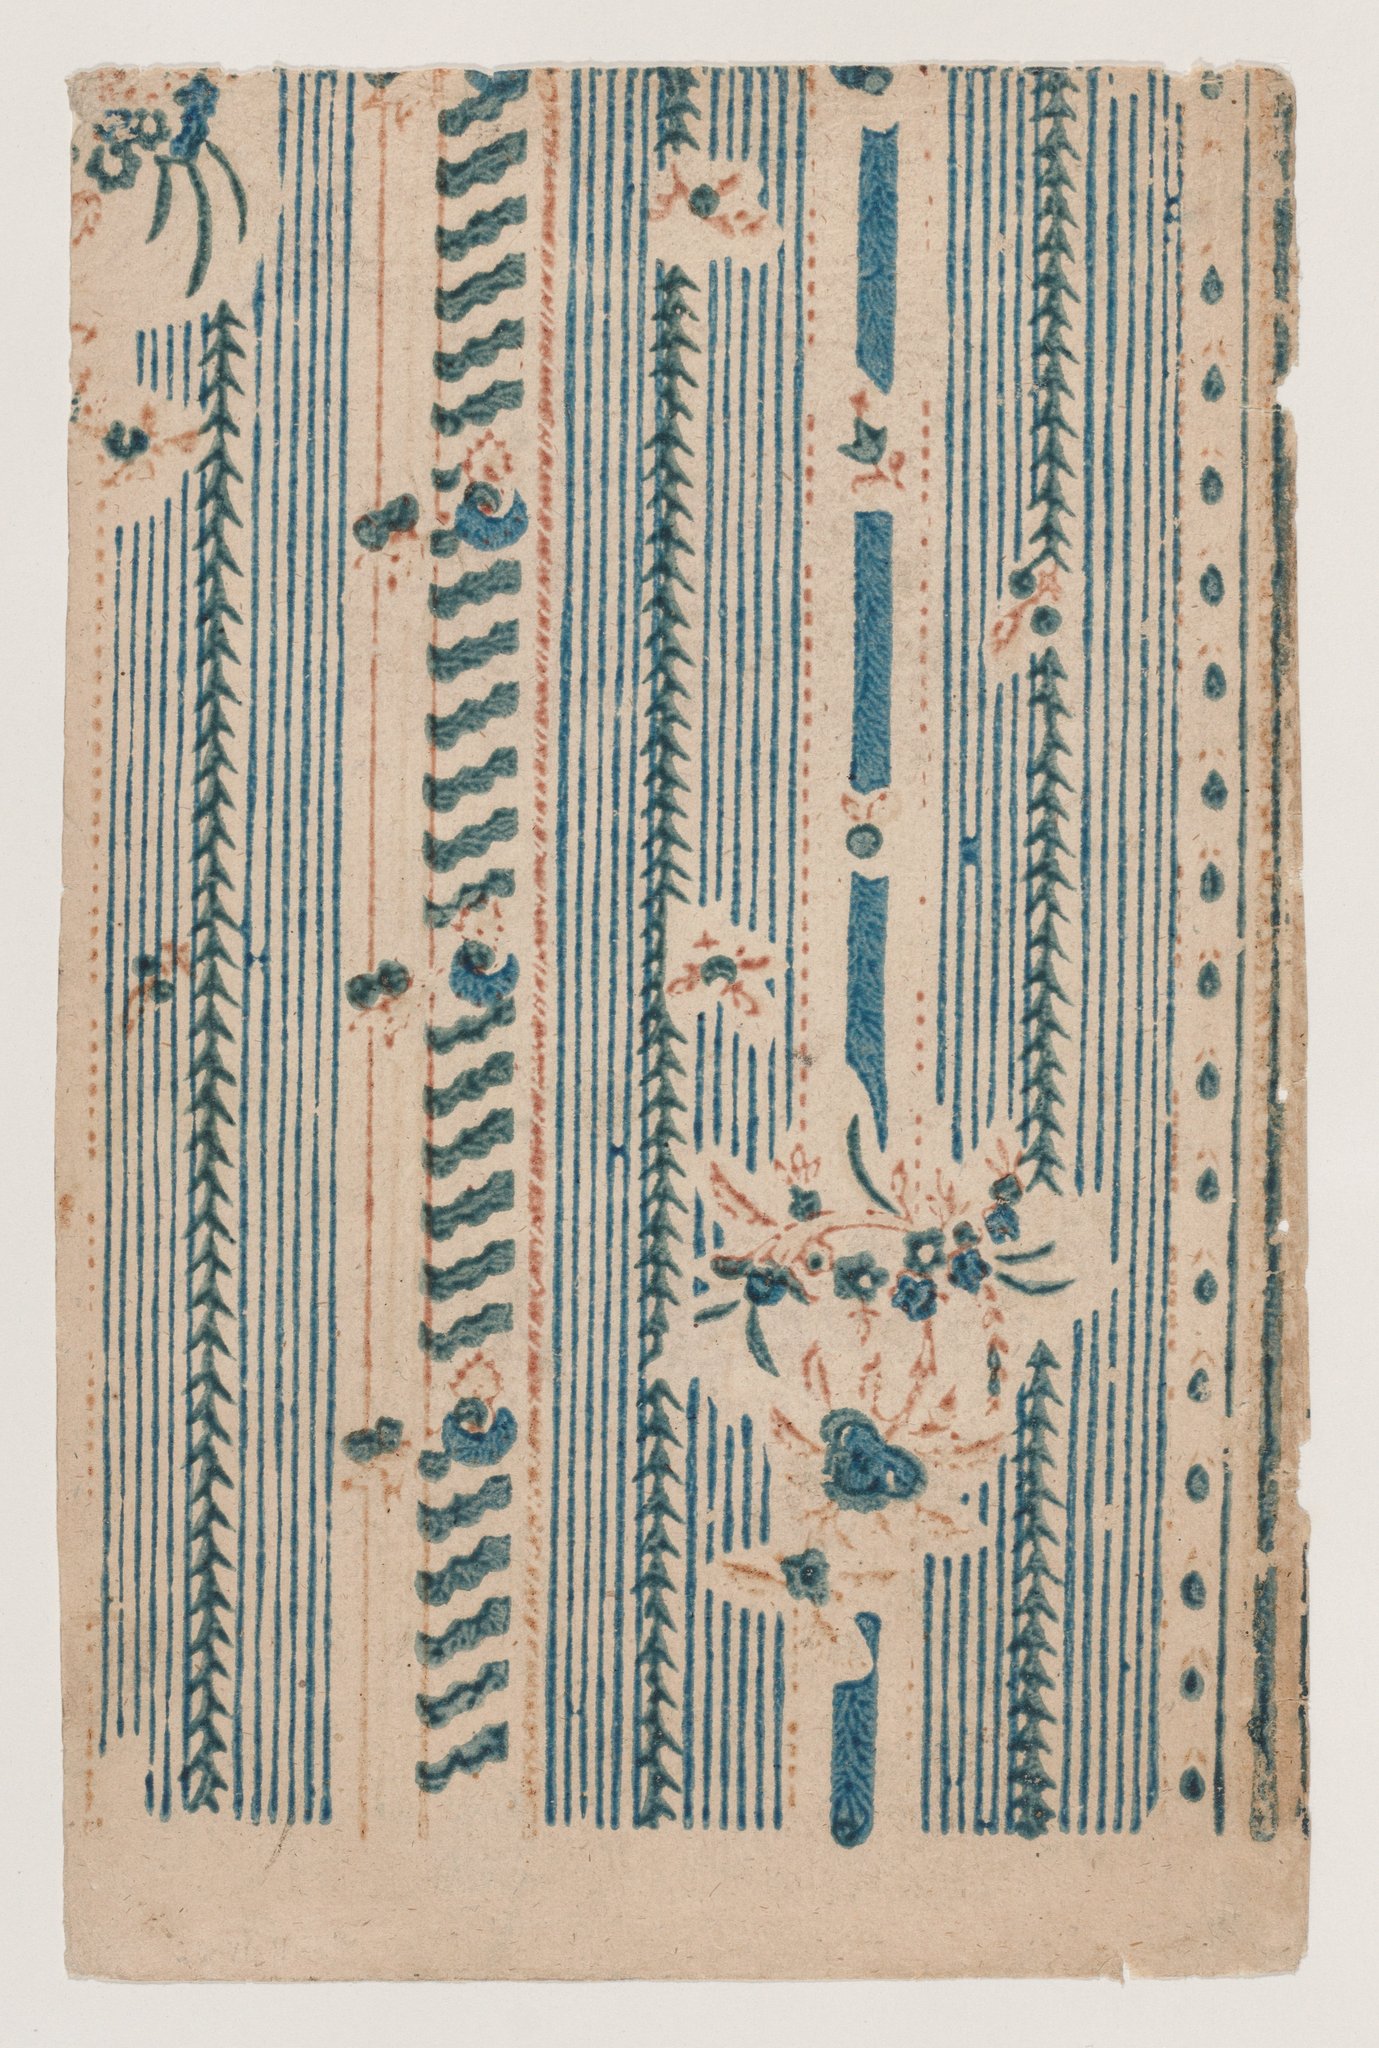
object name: print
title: Sheet with striped and abstract pattern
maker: Anonymous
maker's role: artist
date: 1801-1900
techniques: relief print